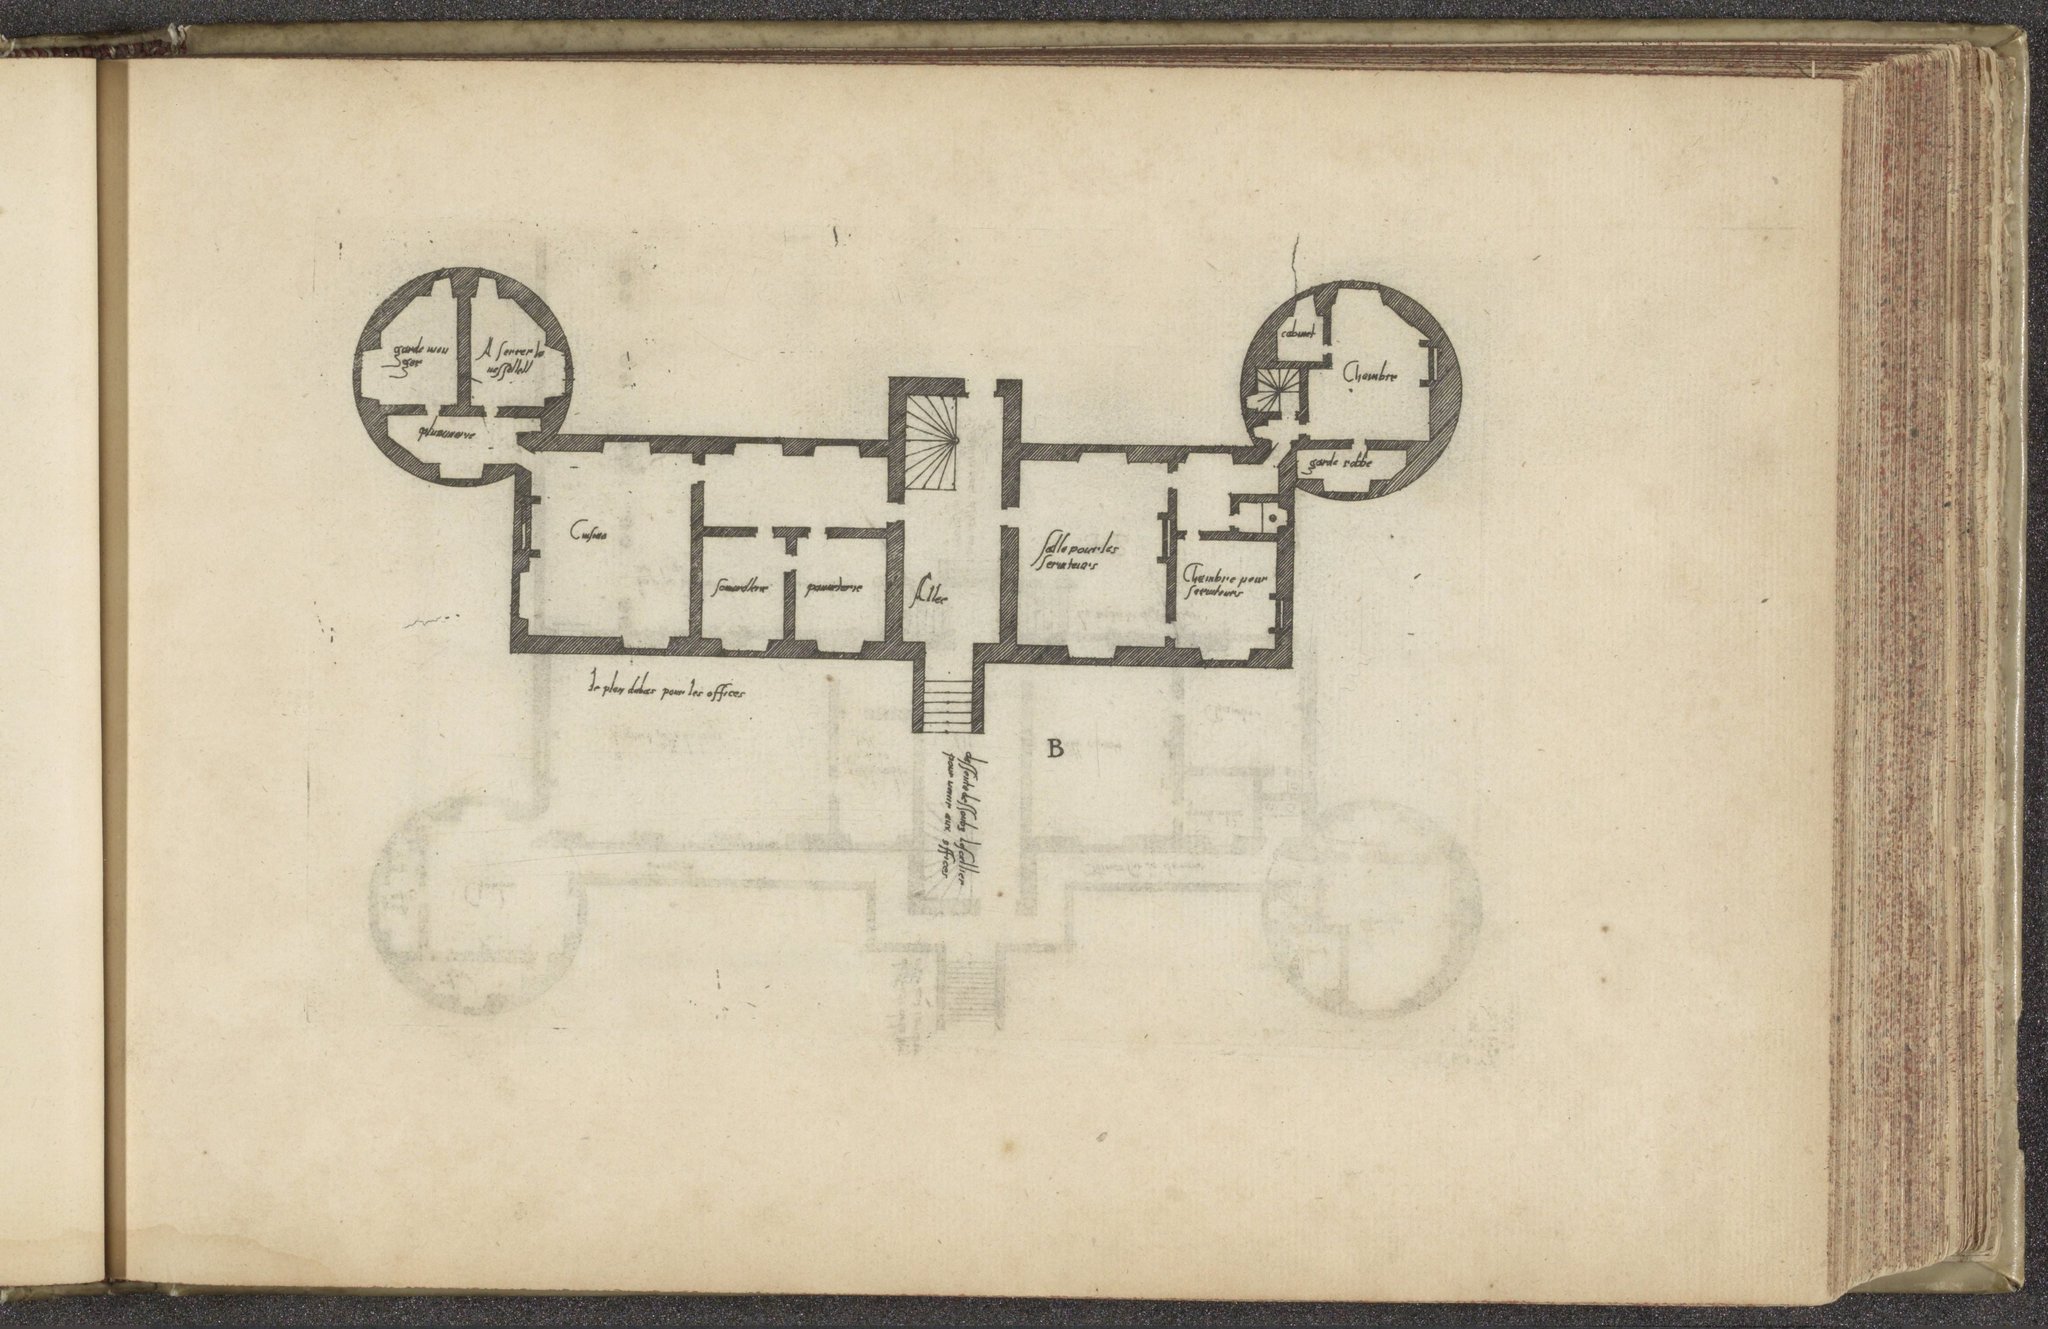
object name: album leaf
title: Logis domestiques / Petit Habitations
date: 1540-1545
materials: paper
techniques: etching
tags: plan ~ architecture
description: Deze prent maakt deel uit van een album.